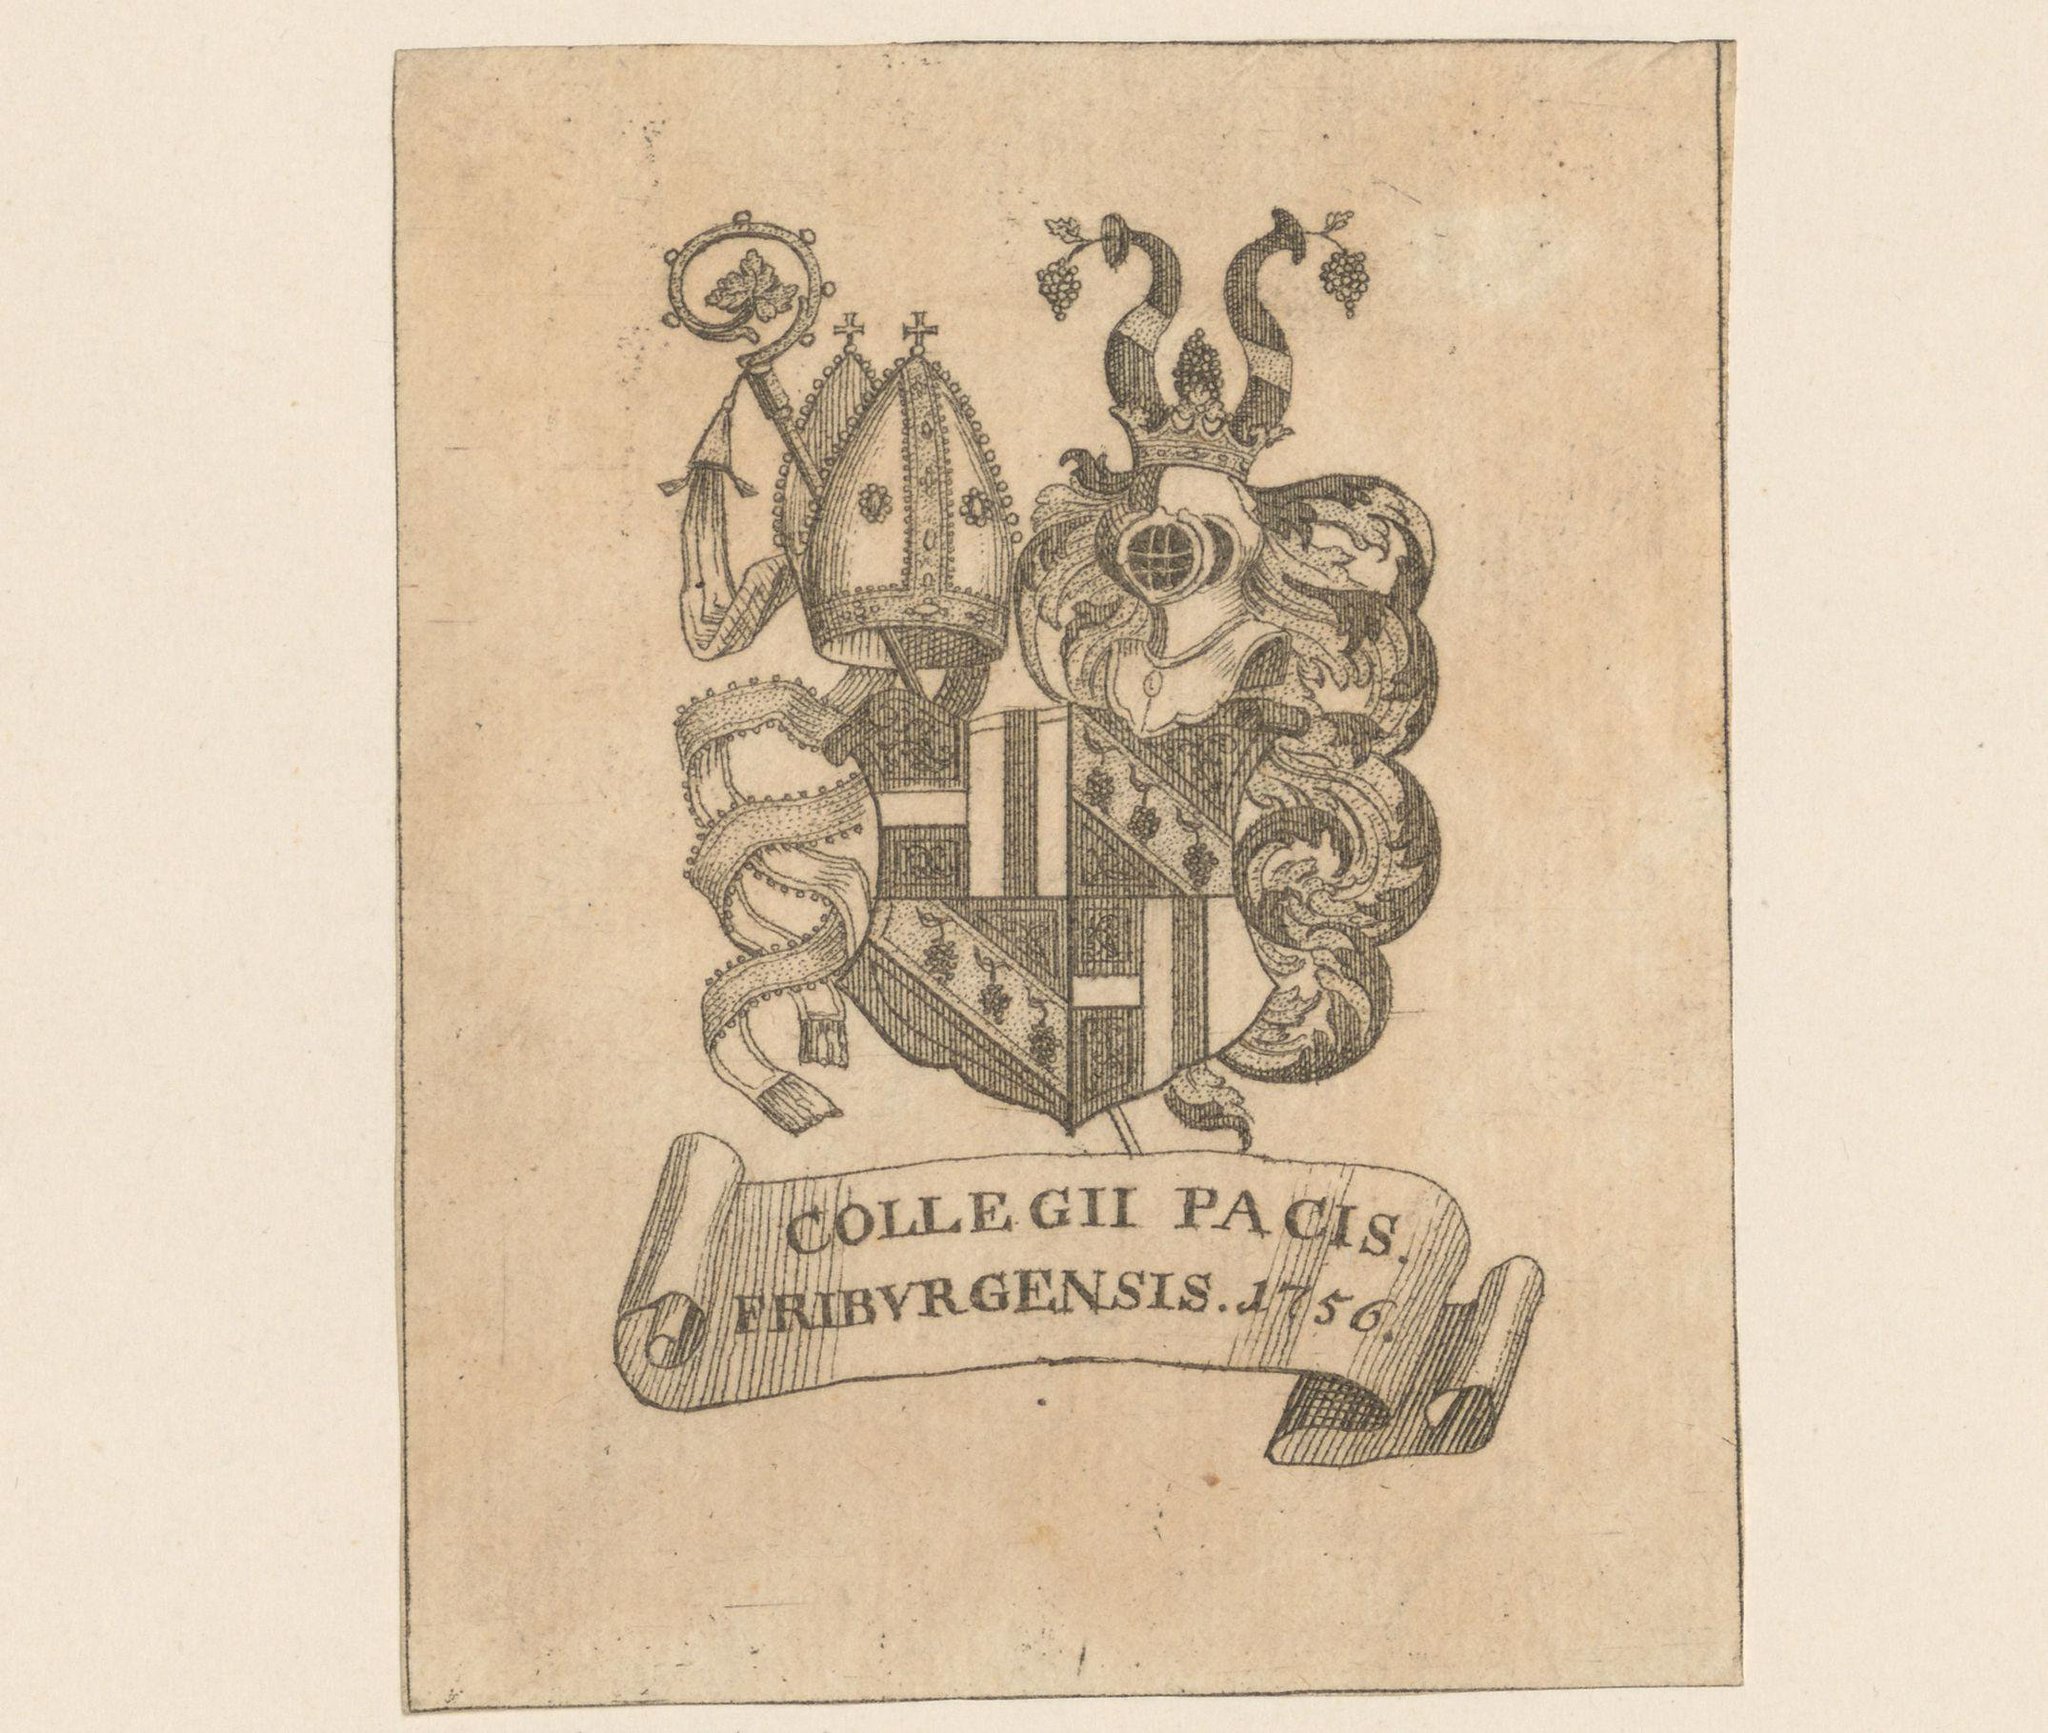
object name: bookplate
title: Collegii Pacis Friburgensis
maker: Anonymous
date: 1756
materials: paper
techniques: etching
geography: germany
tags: insignia of bishop, e.g. mitre, crozier, bunch of grapes, armorial bearing, heraldry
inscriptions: date